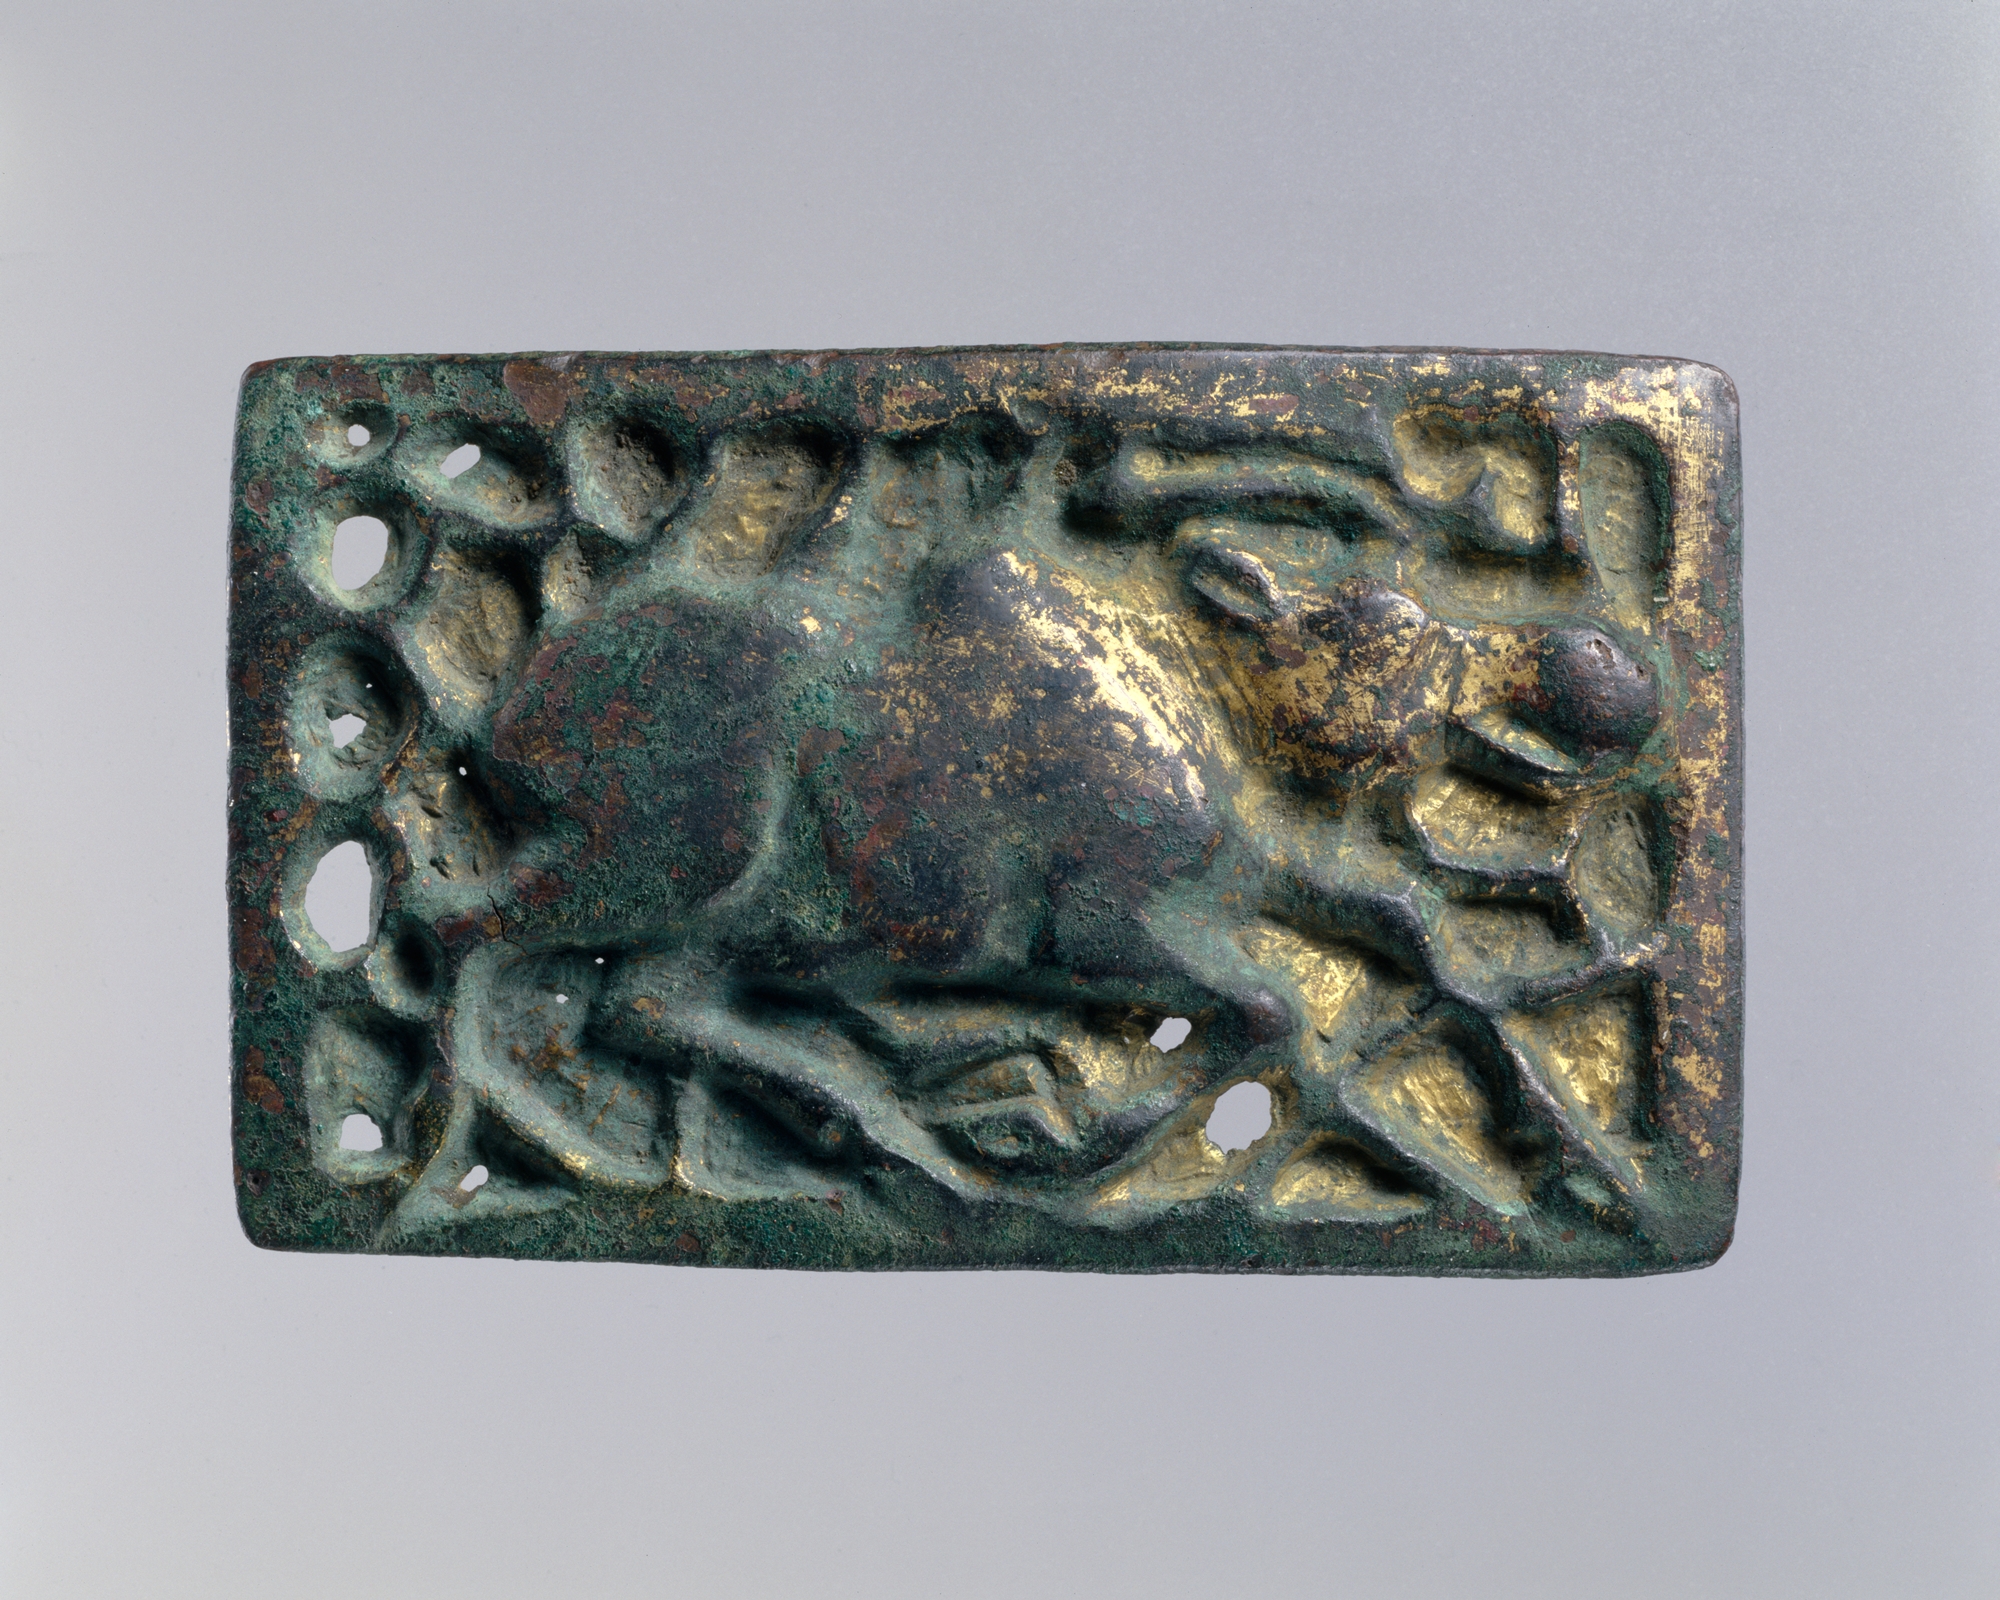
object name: plaque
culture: north chinese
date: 300-1 BCE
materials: bronze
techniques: gilding